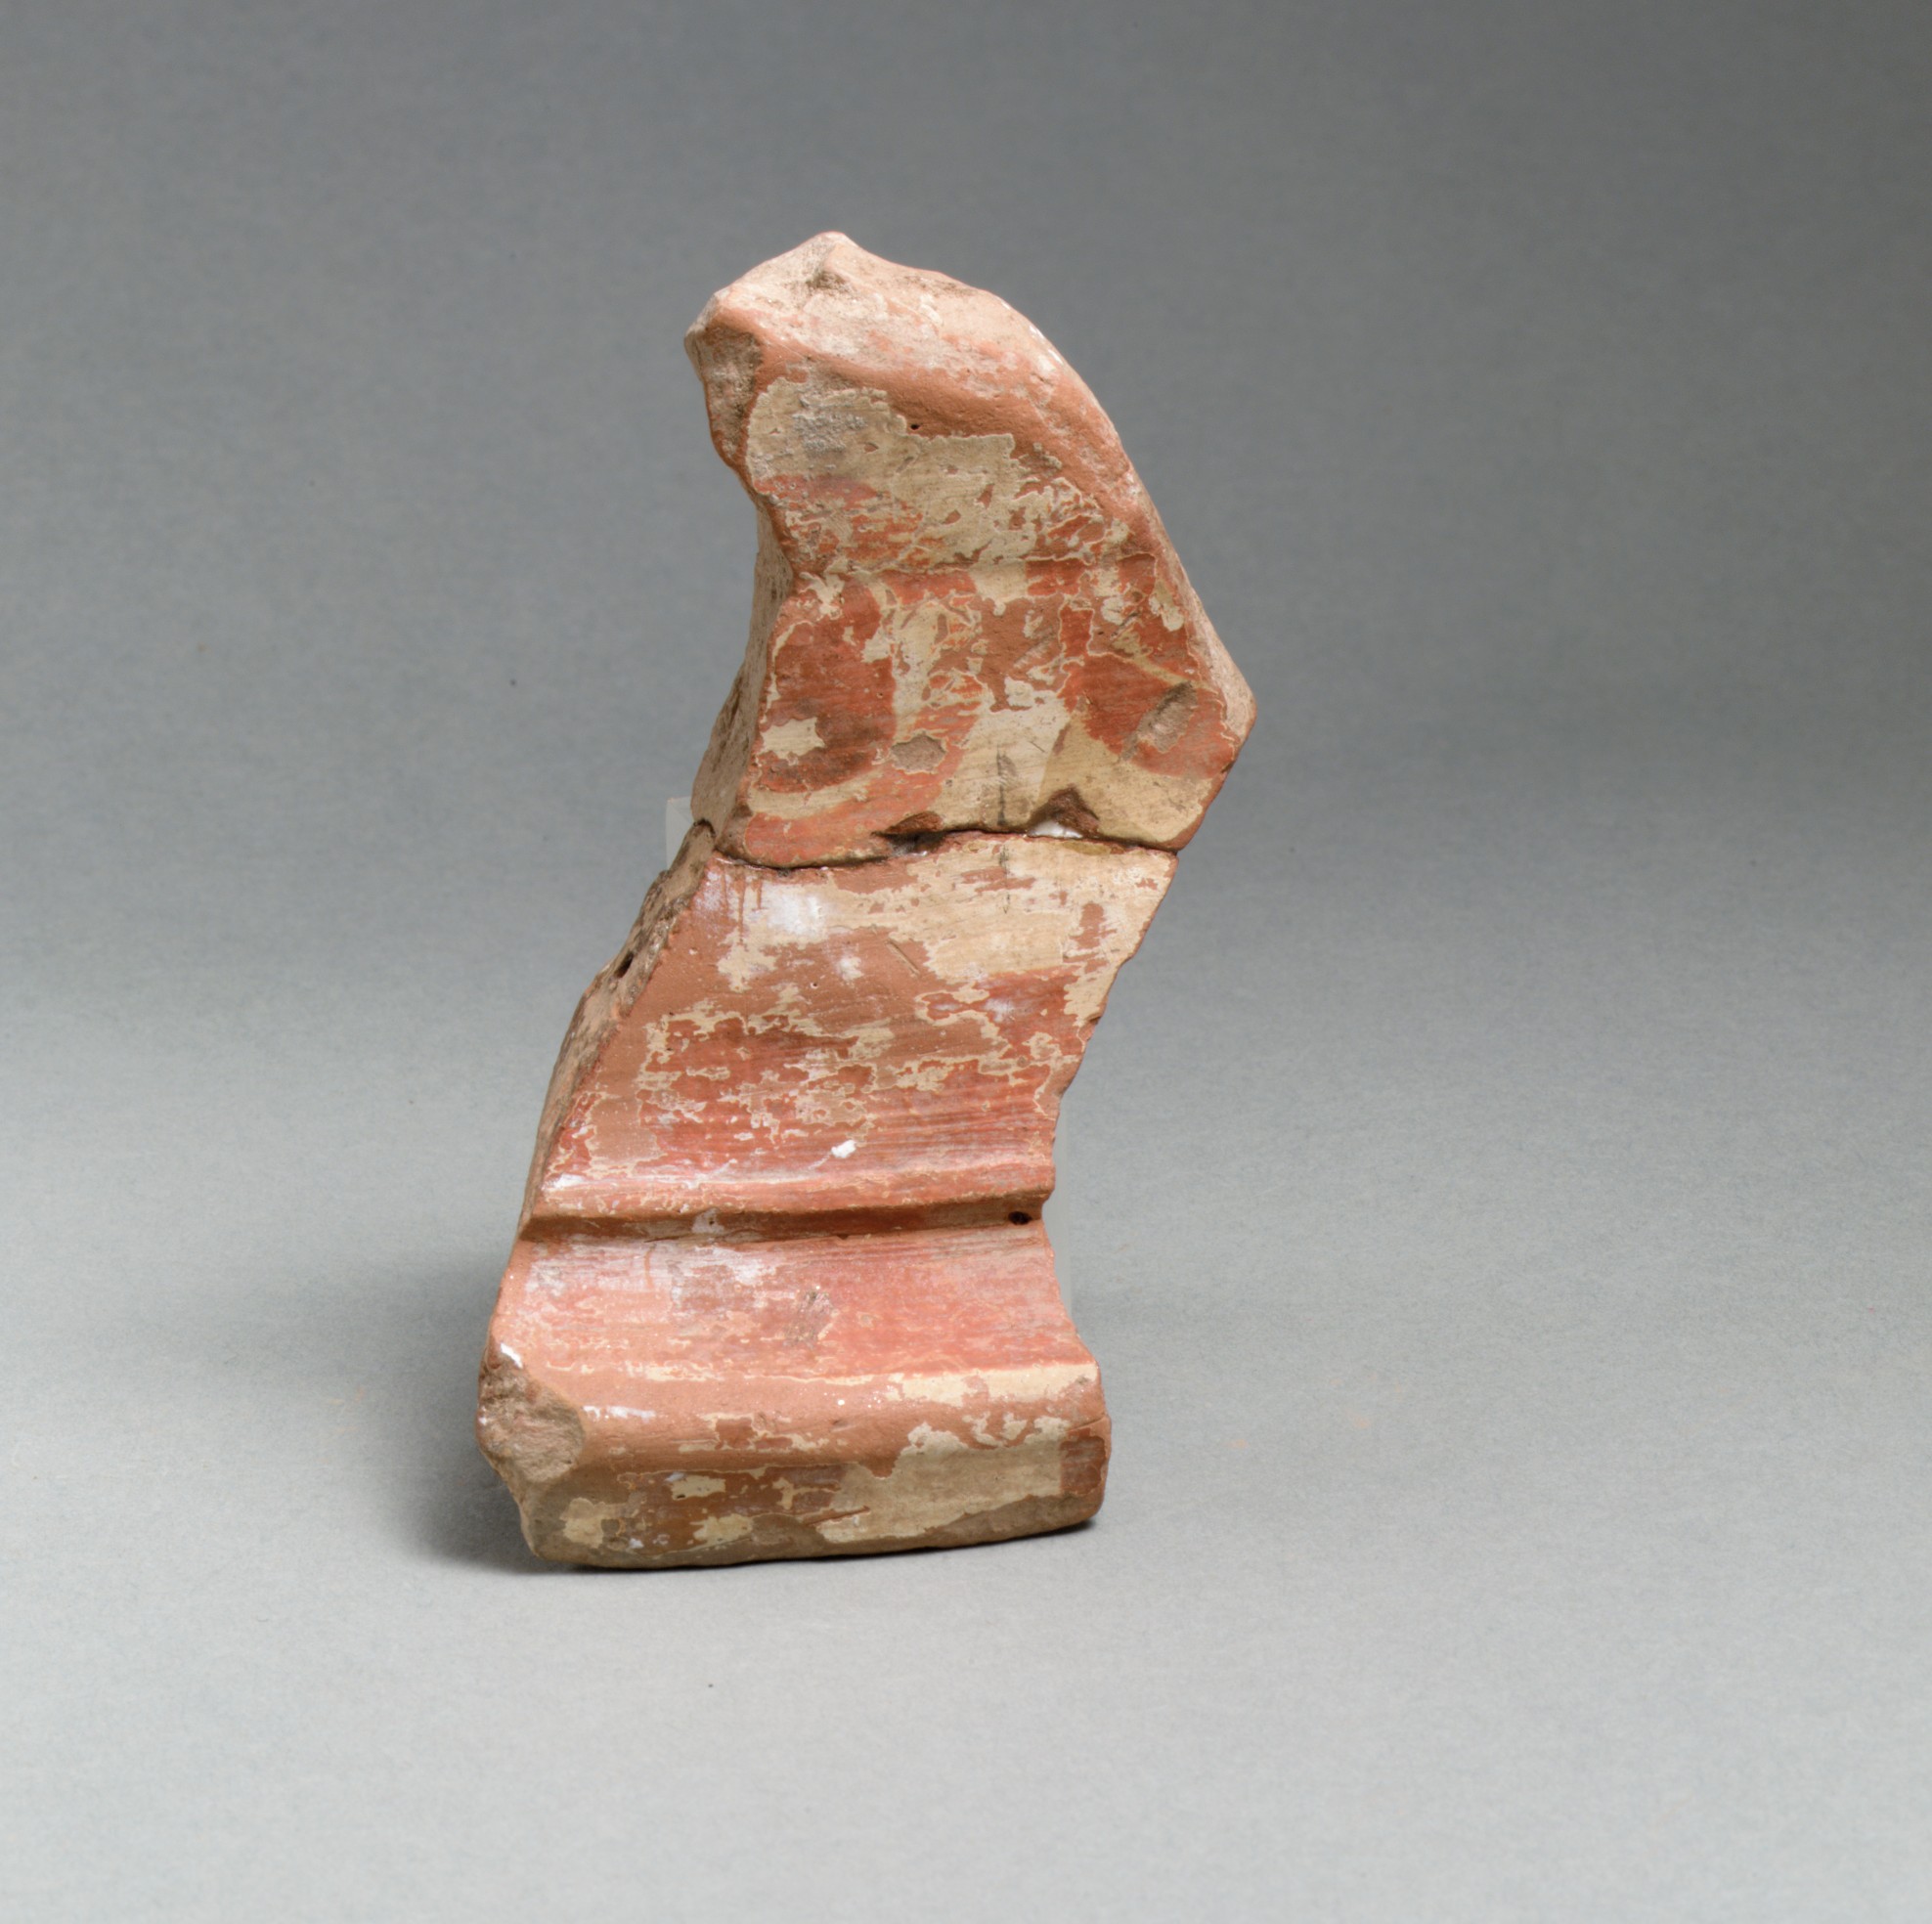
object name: vase fragment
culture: greek or lydian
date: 900-30 BCE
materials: terracotta